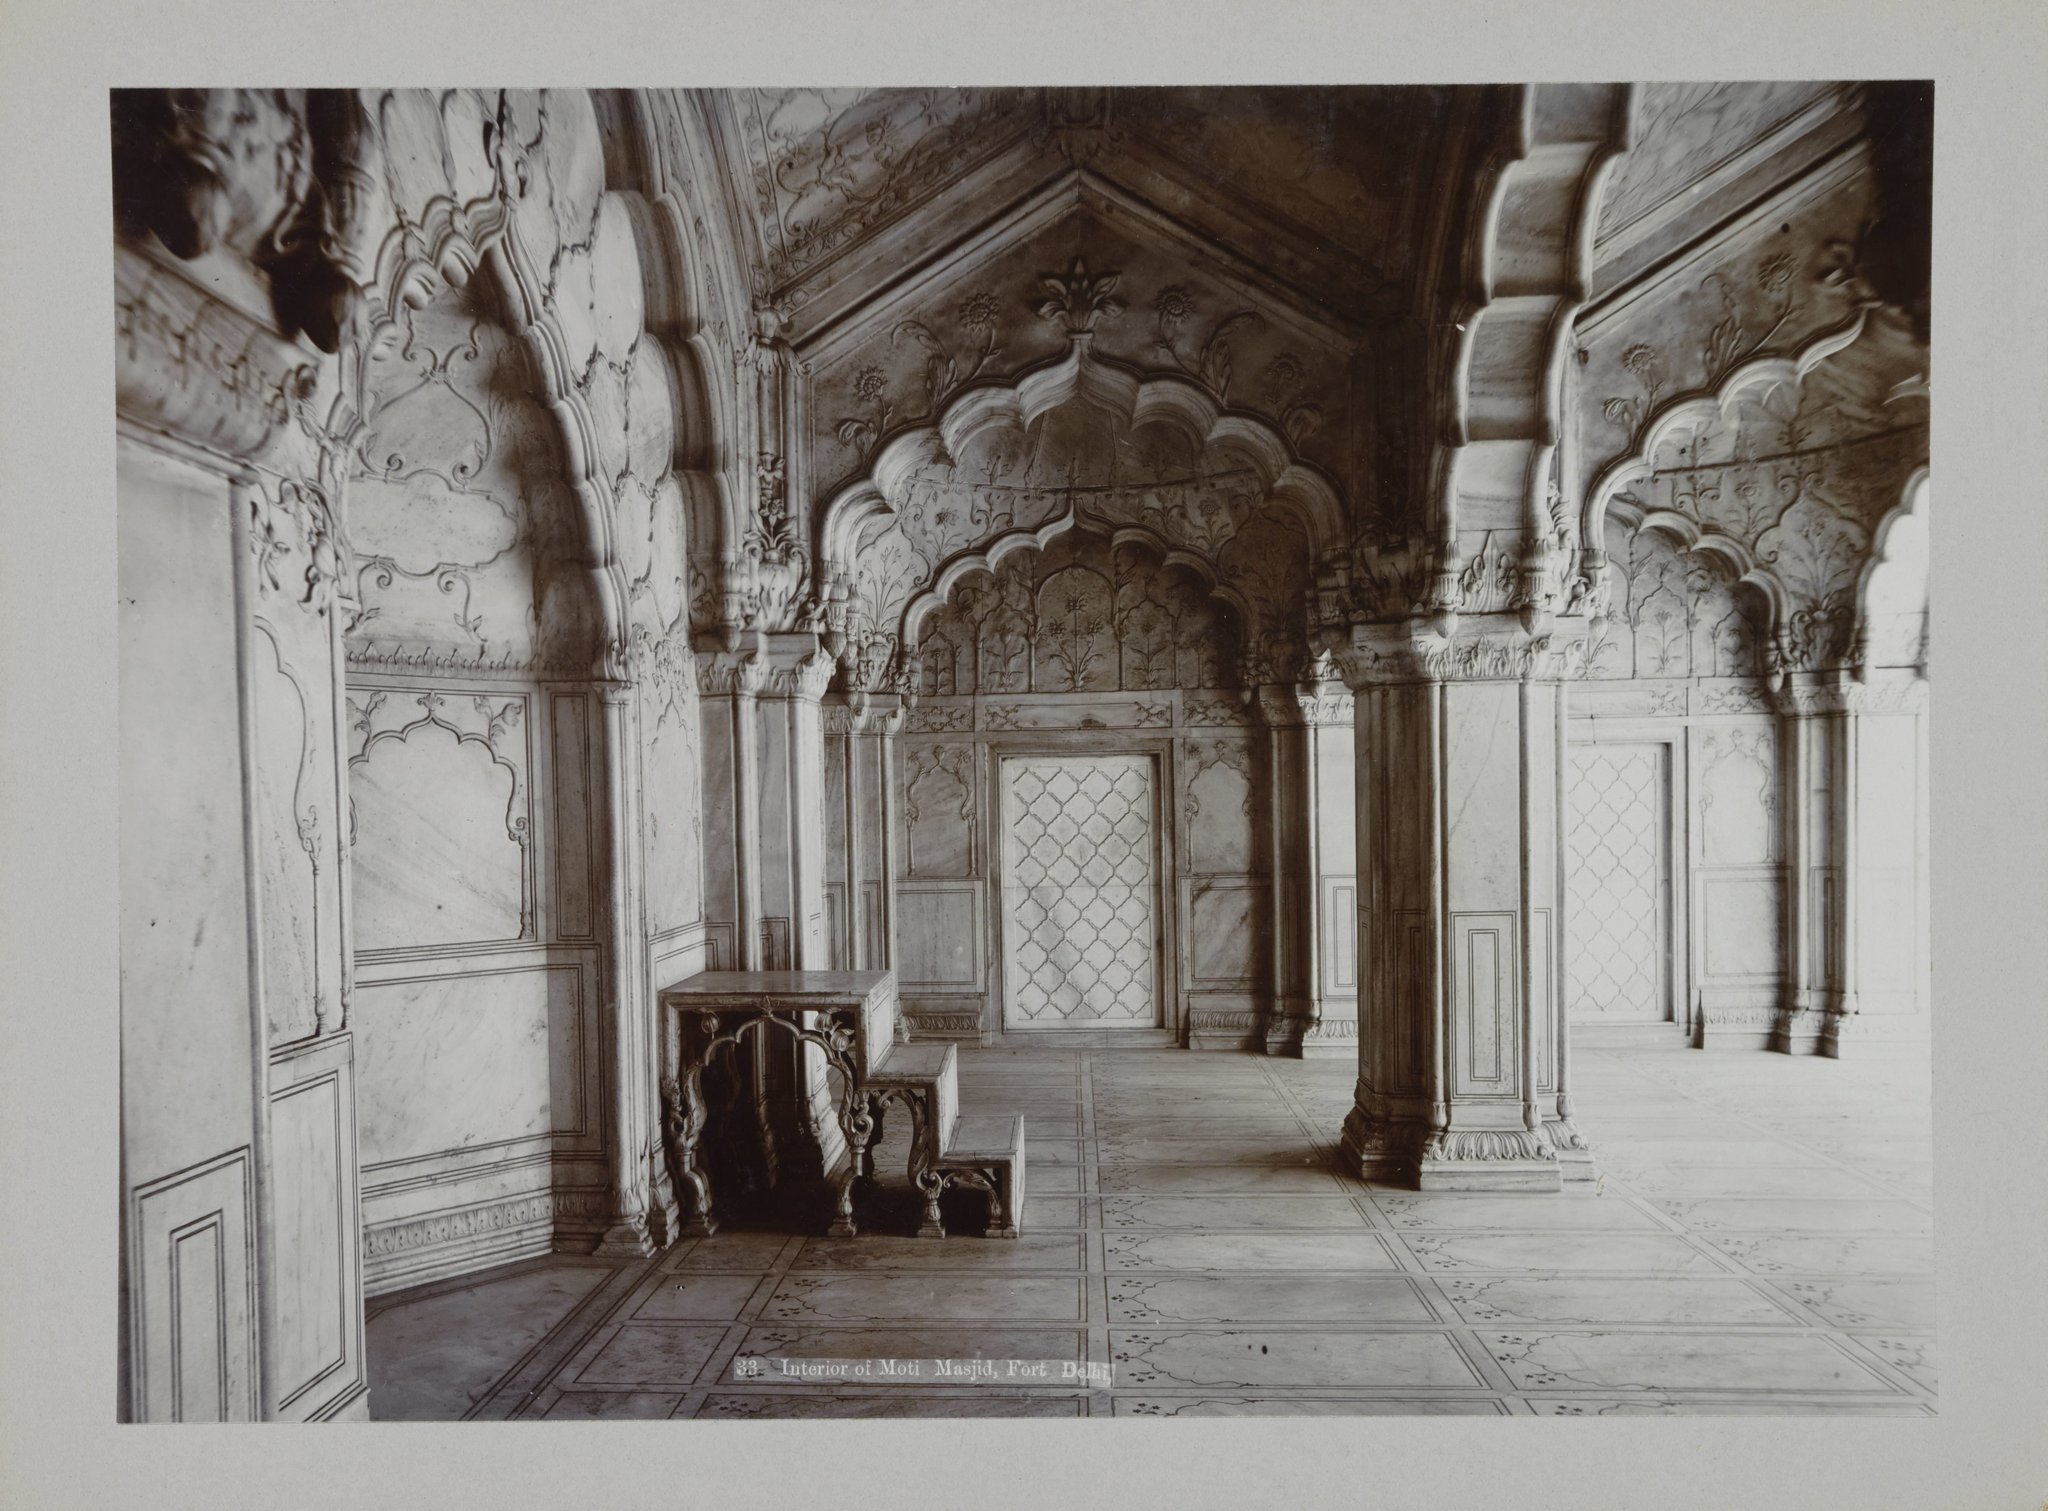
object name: photograph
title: Interior of the Pearl Mosque (Moti Masjid) in the Red Fort at Delhi, India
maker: Anonymous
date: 1895-1915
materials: cardboard, paper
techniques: gelatin silver print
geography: delhi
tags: delhi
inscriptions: number: ‘22.’, inscription: ‘33 Interior of Moti Masjid, Fort Delhi’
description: De Parelmoskee staat binnen het Rode Fort van Delhi.